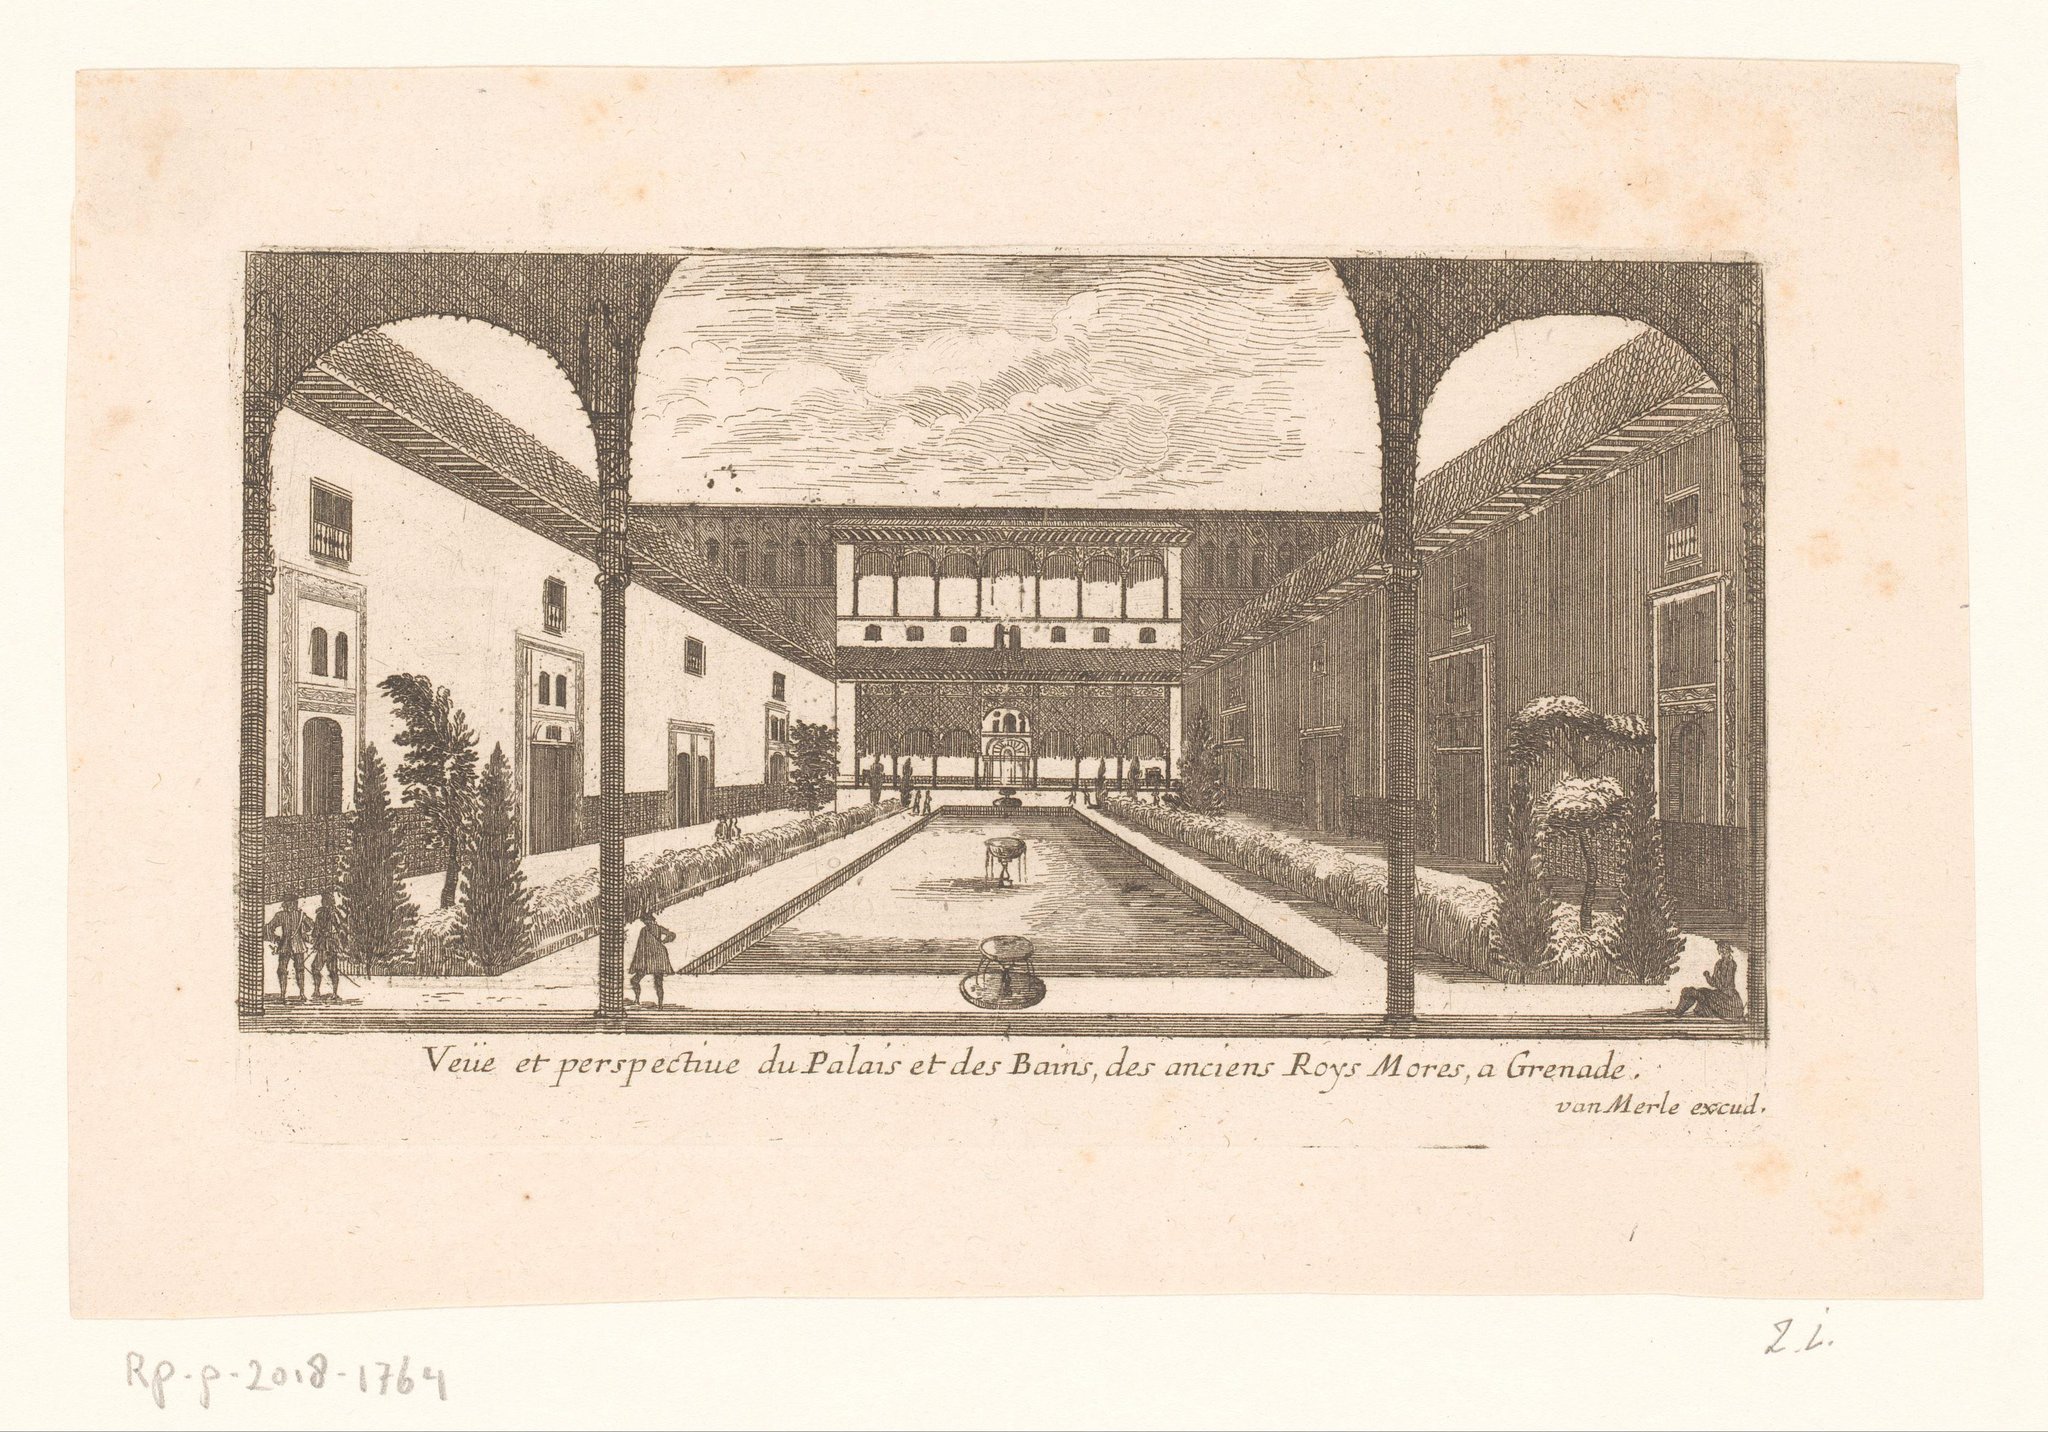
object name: print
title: Veüe et perspective du palais et des bains, des anciens roys Mores de Grenade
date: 1626-1686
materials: paper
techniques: etching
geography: antwerp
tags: garden fountain, palace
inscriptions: collector's mark: Lugt 2228